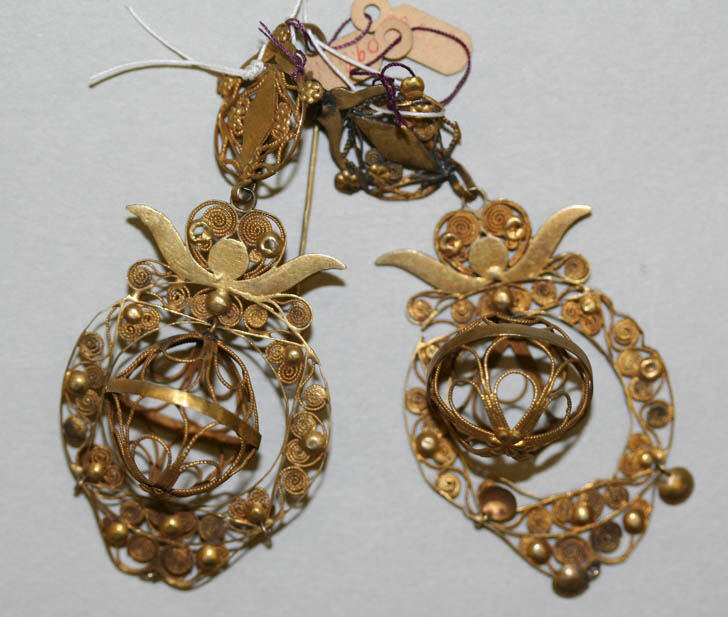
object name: earring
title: Earrings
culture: european, eastern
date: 1701-1900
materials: metal